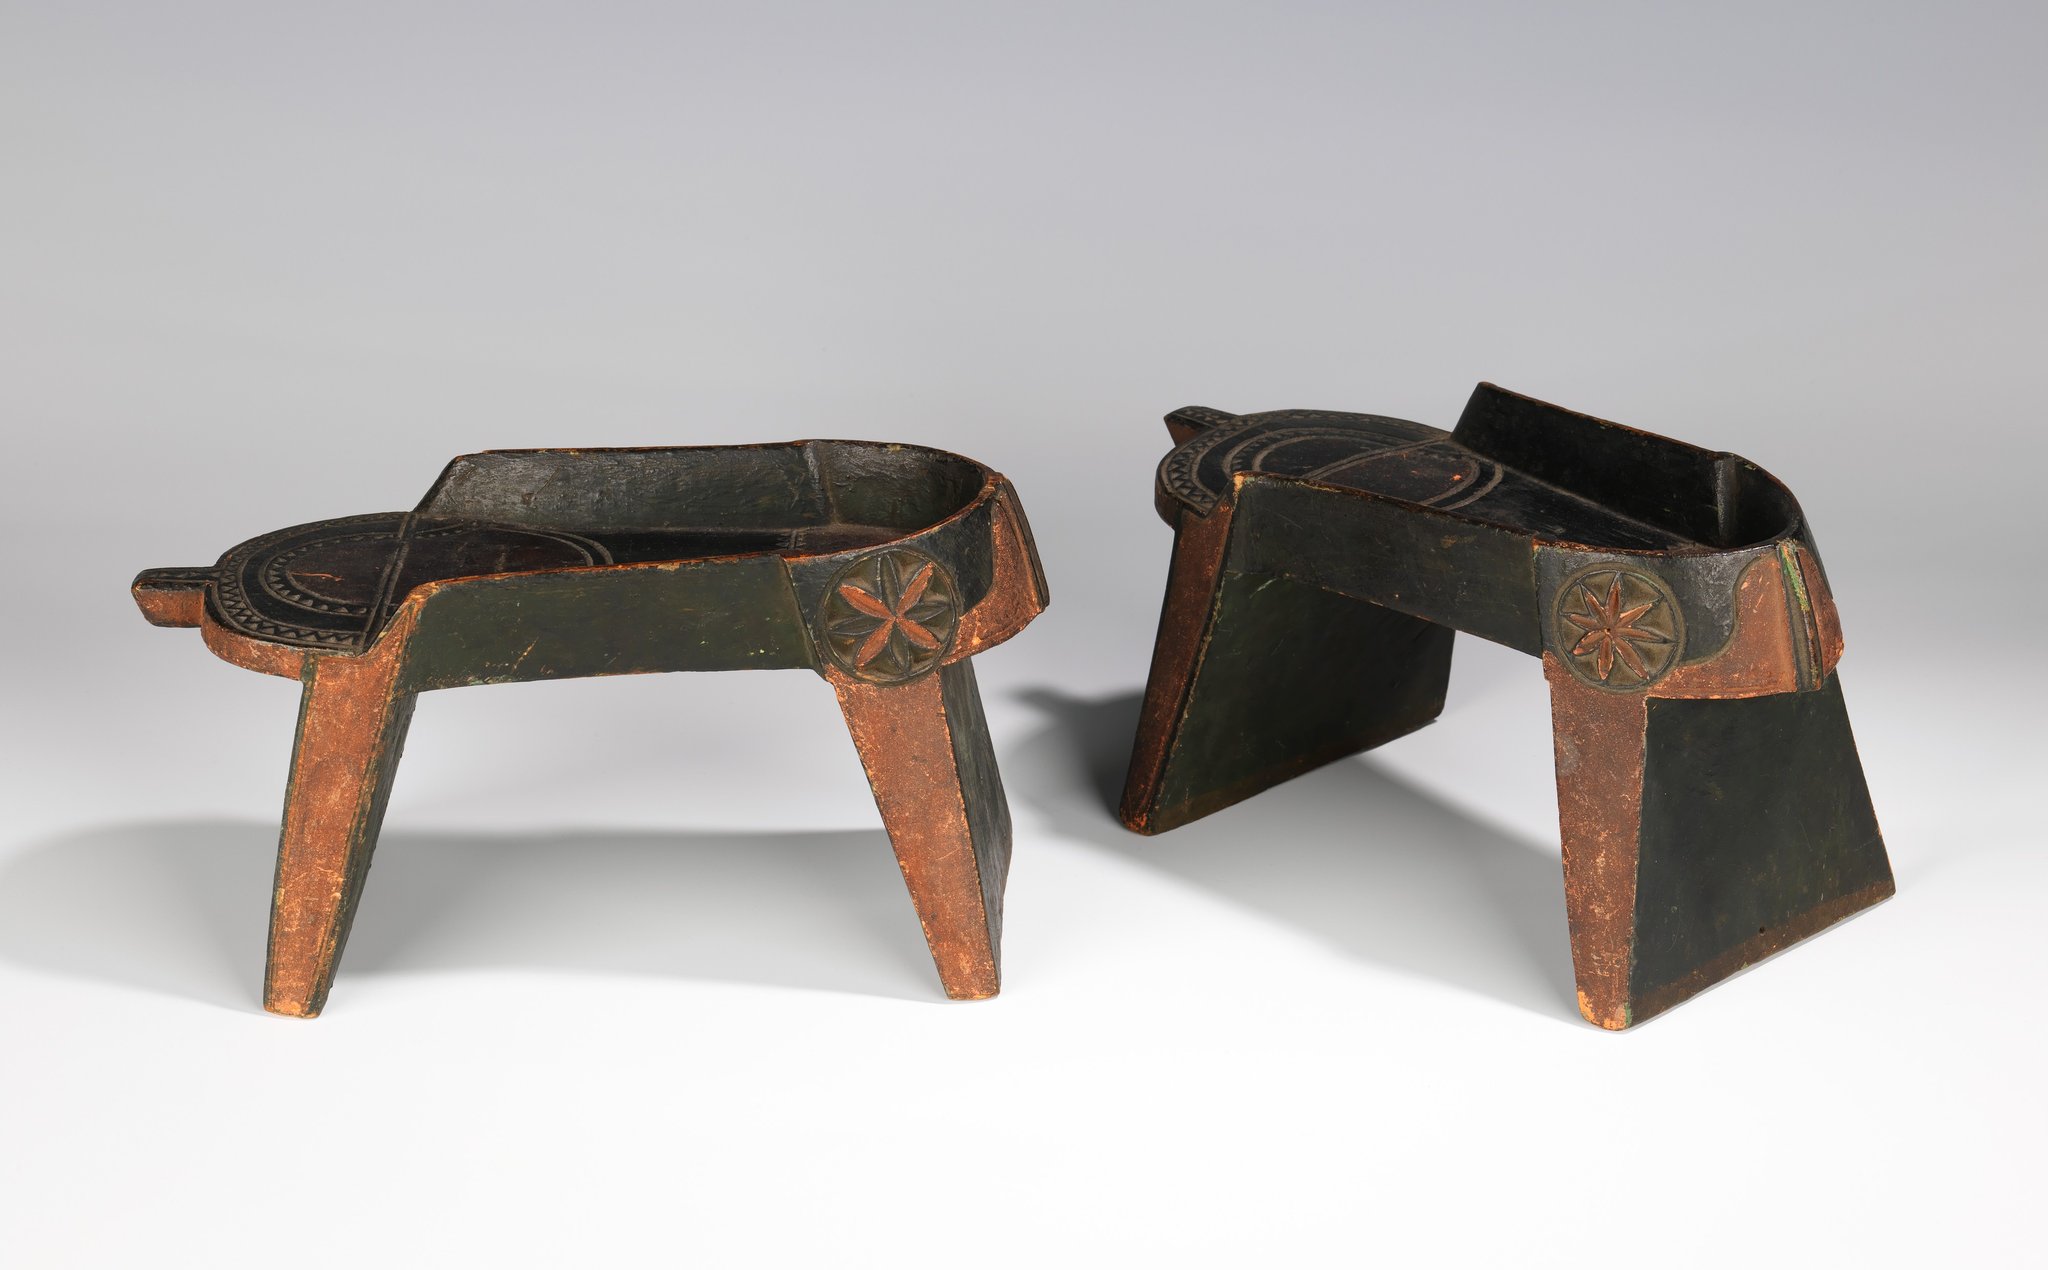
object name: patten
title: Pattens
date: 1801-1900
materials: wood